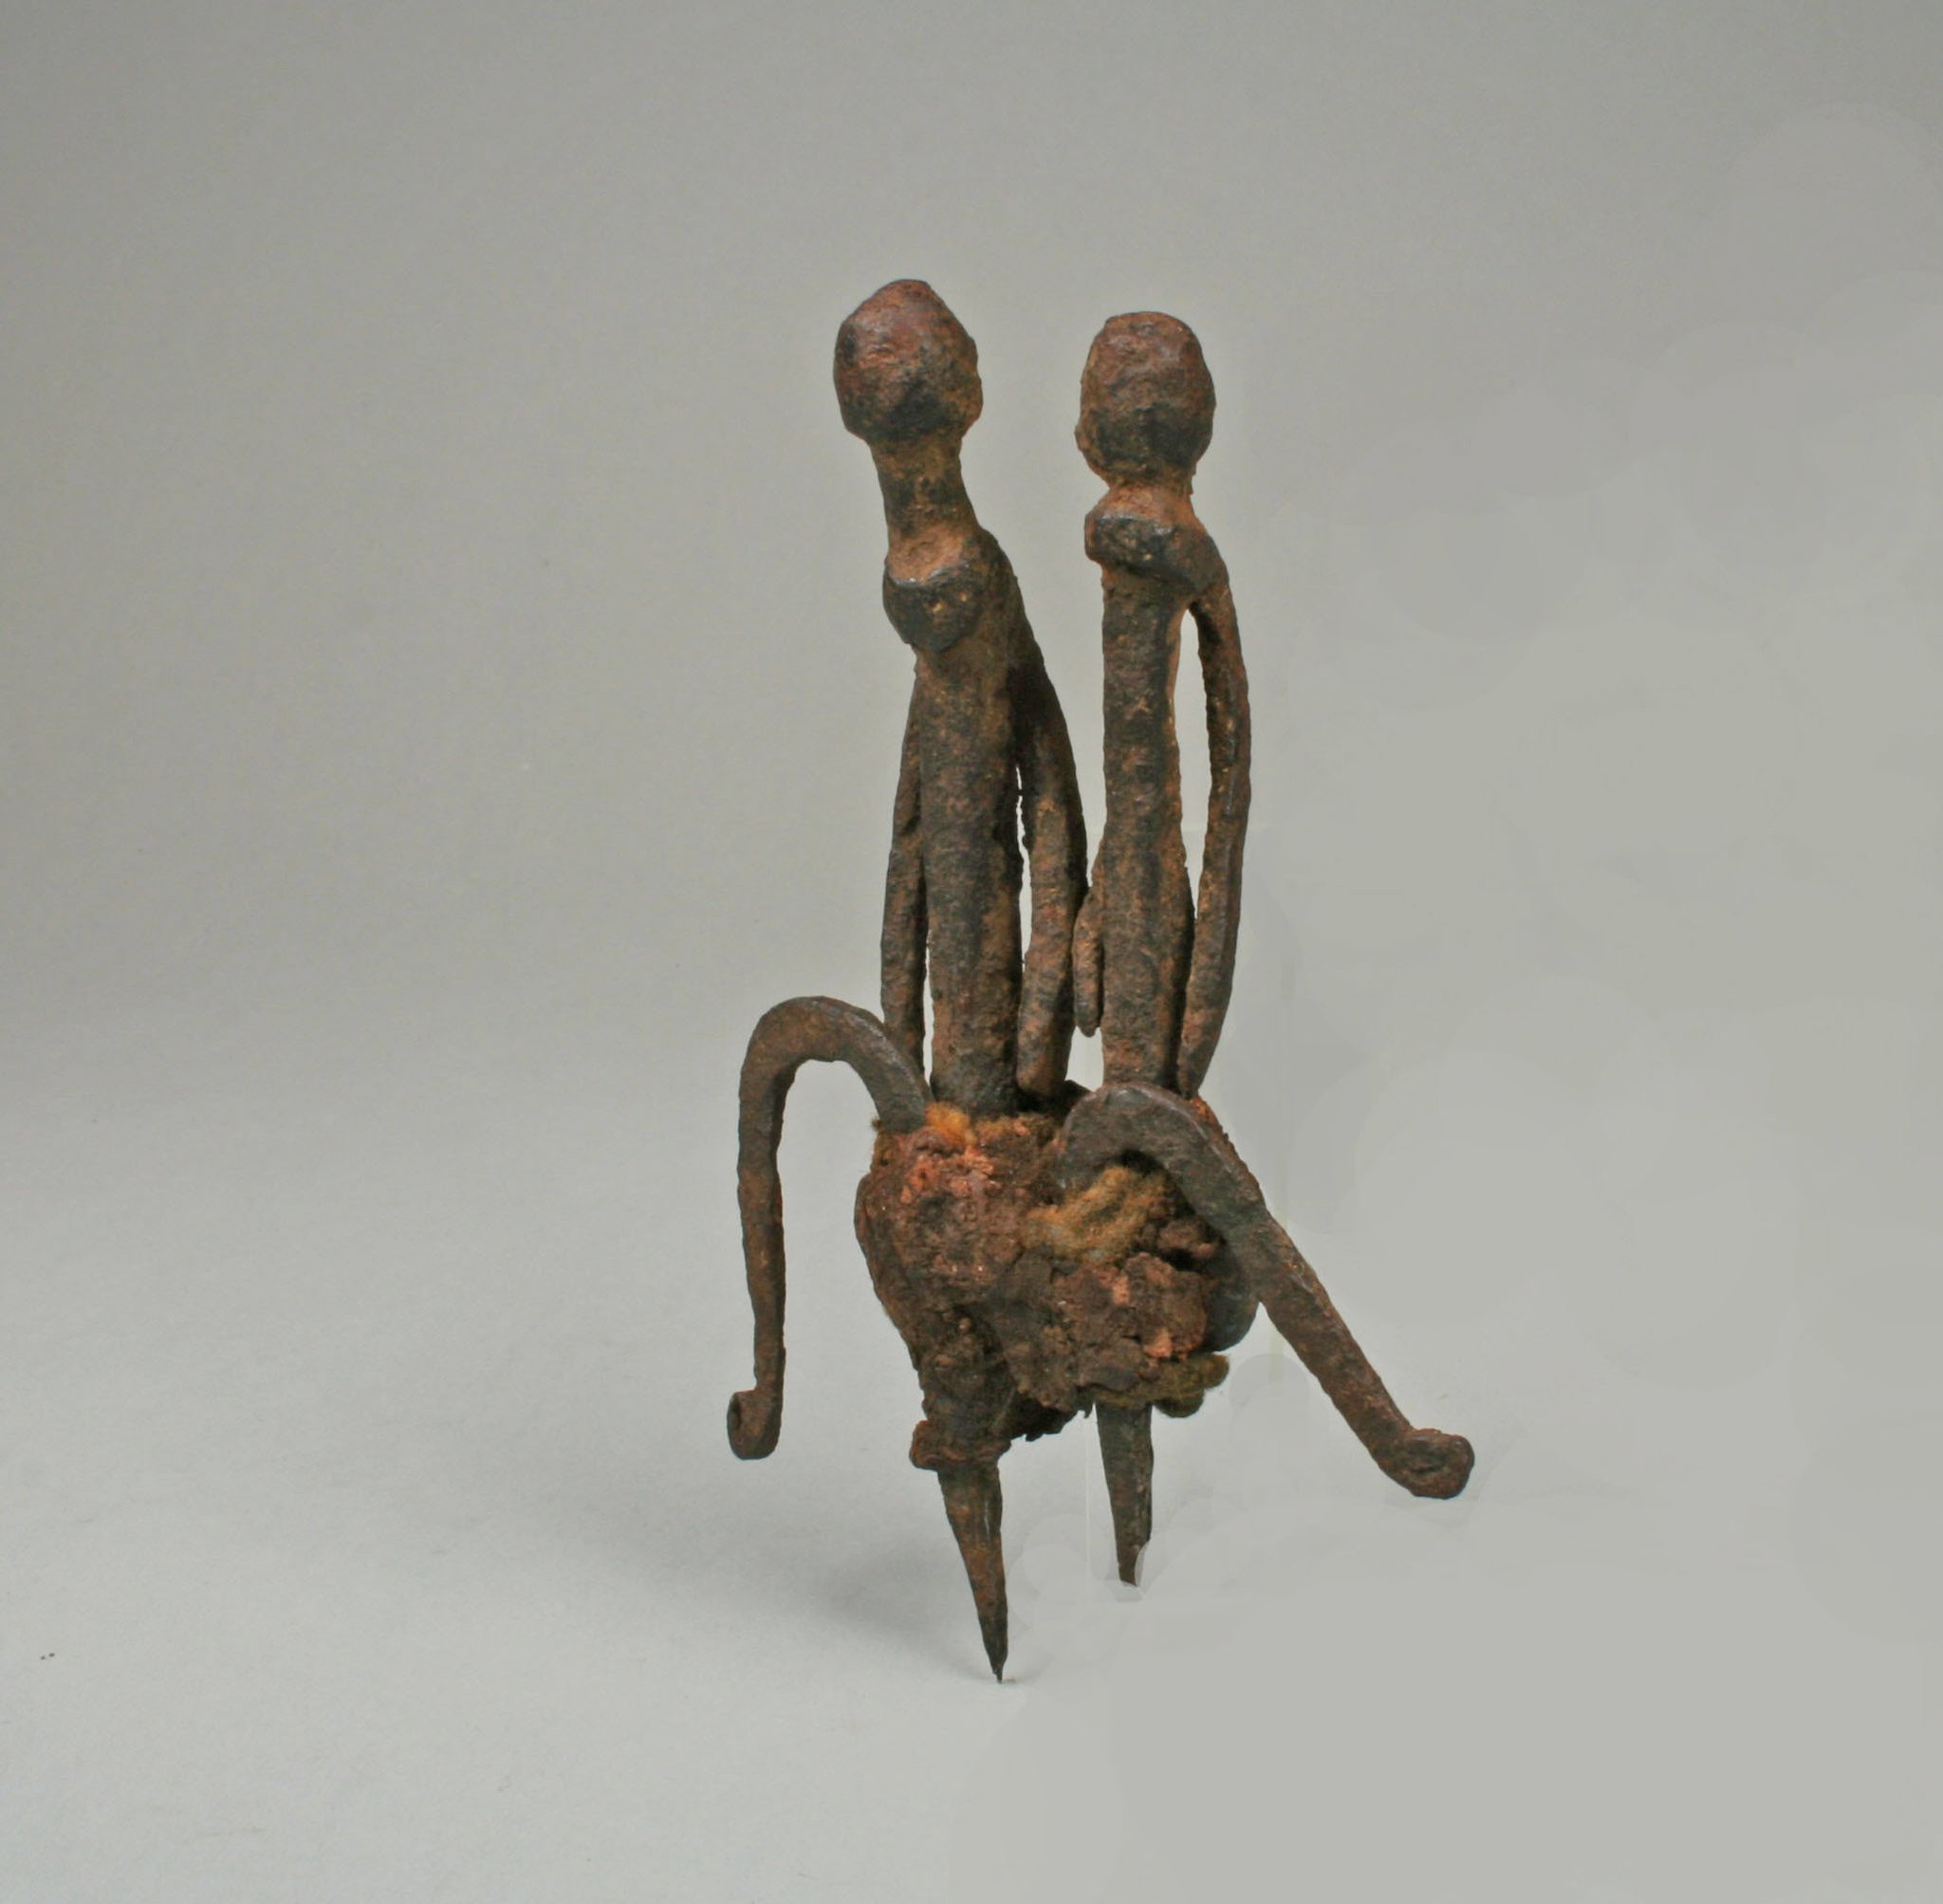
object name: ornamental figure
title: Figures Ornament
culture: dogon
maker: dogon blacksmith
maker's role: artist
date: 1701-1900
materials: iron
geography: mali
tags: human figures